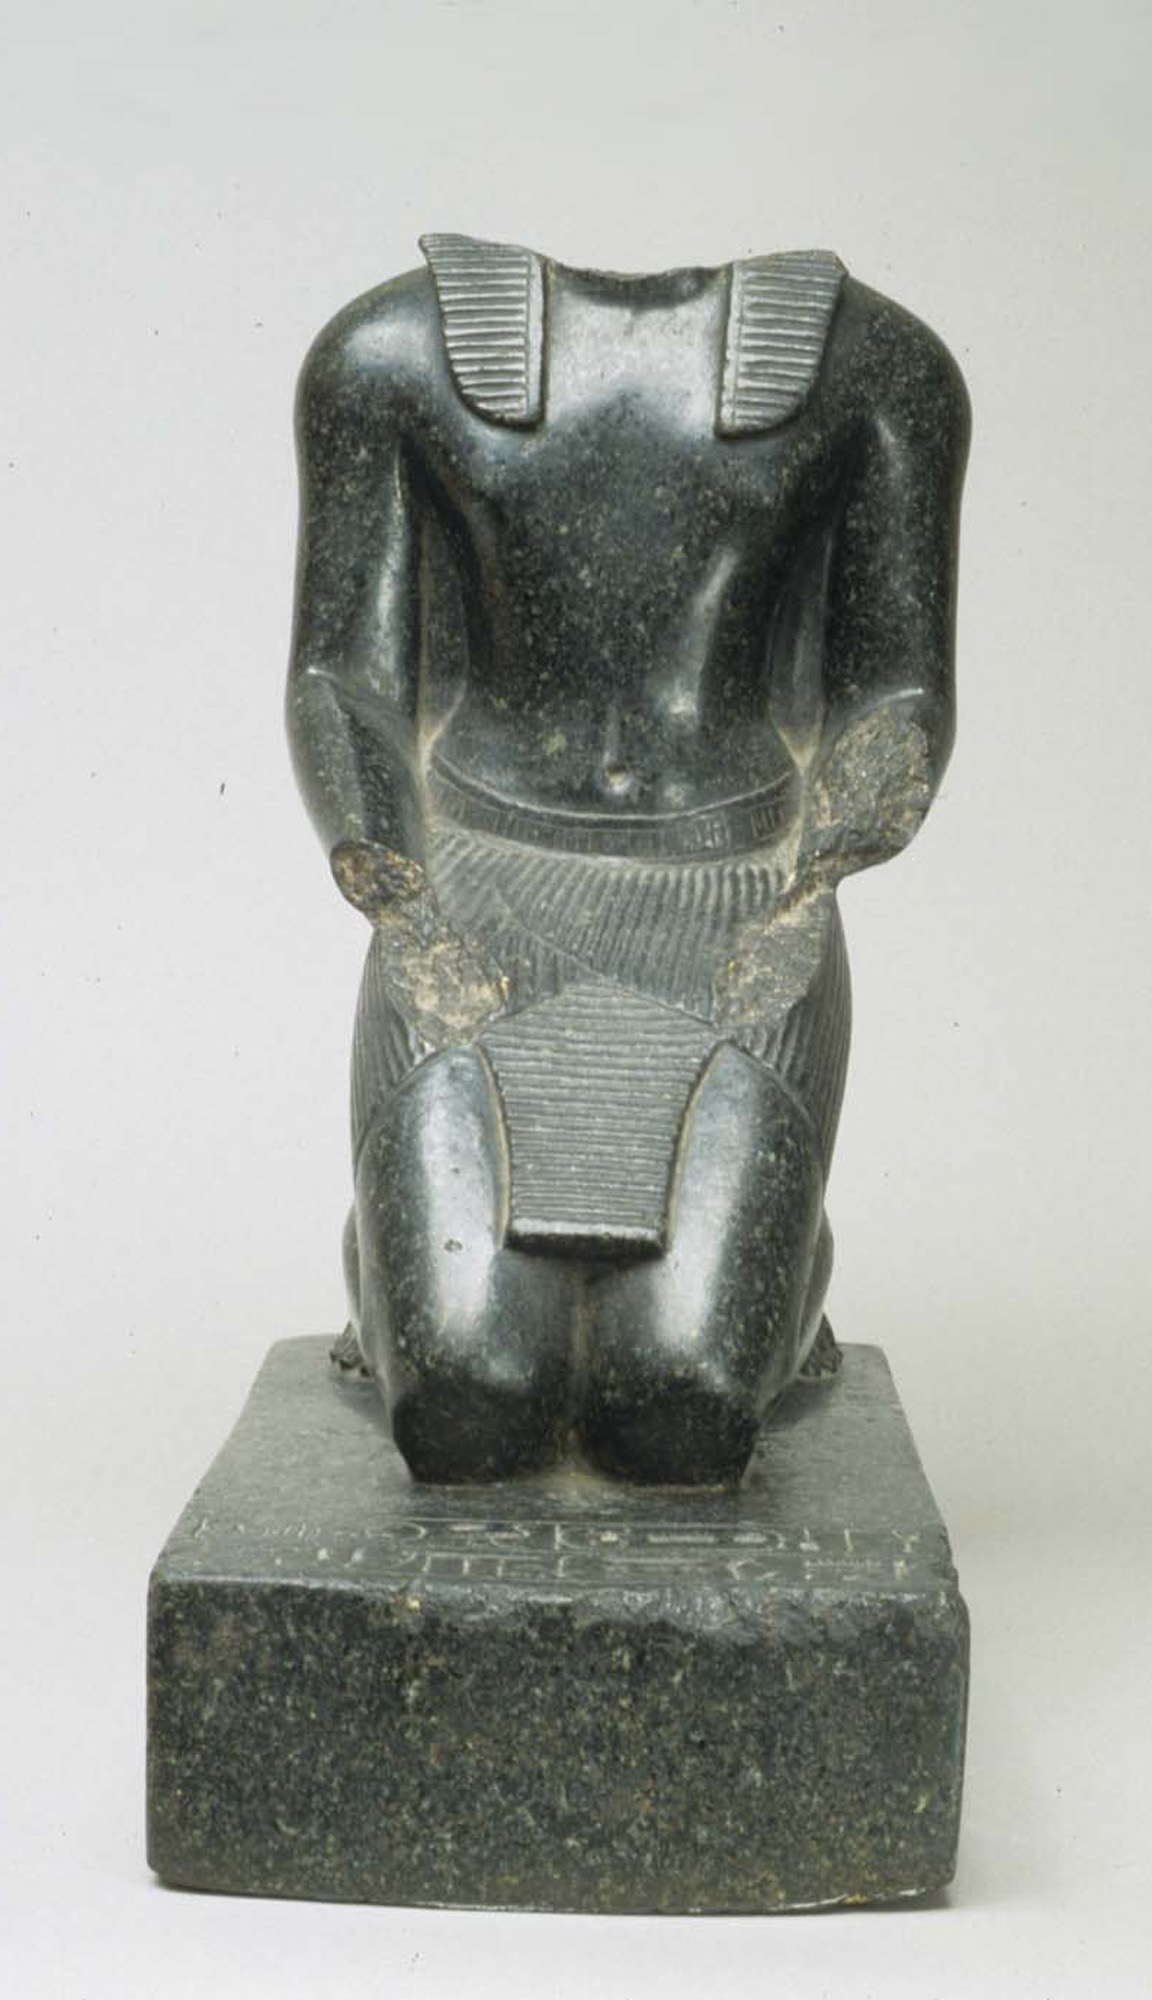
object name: statue, thutmose iii offering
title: Thutmose III Offering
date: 1479-1425 BCE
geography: upper egypt, thebes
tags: men